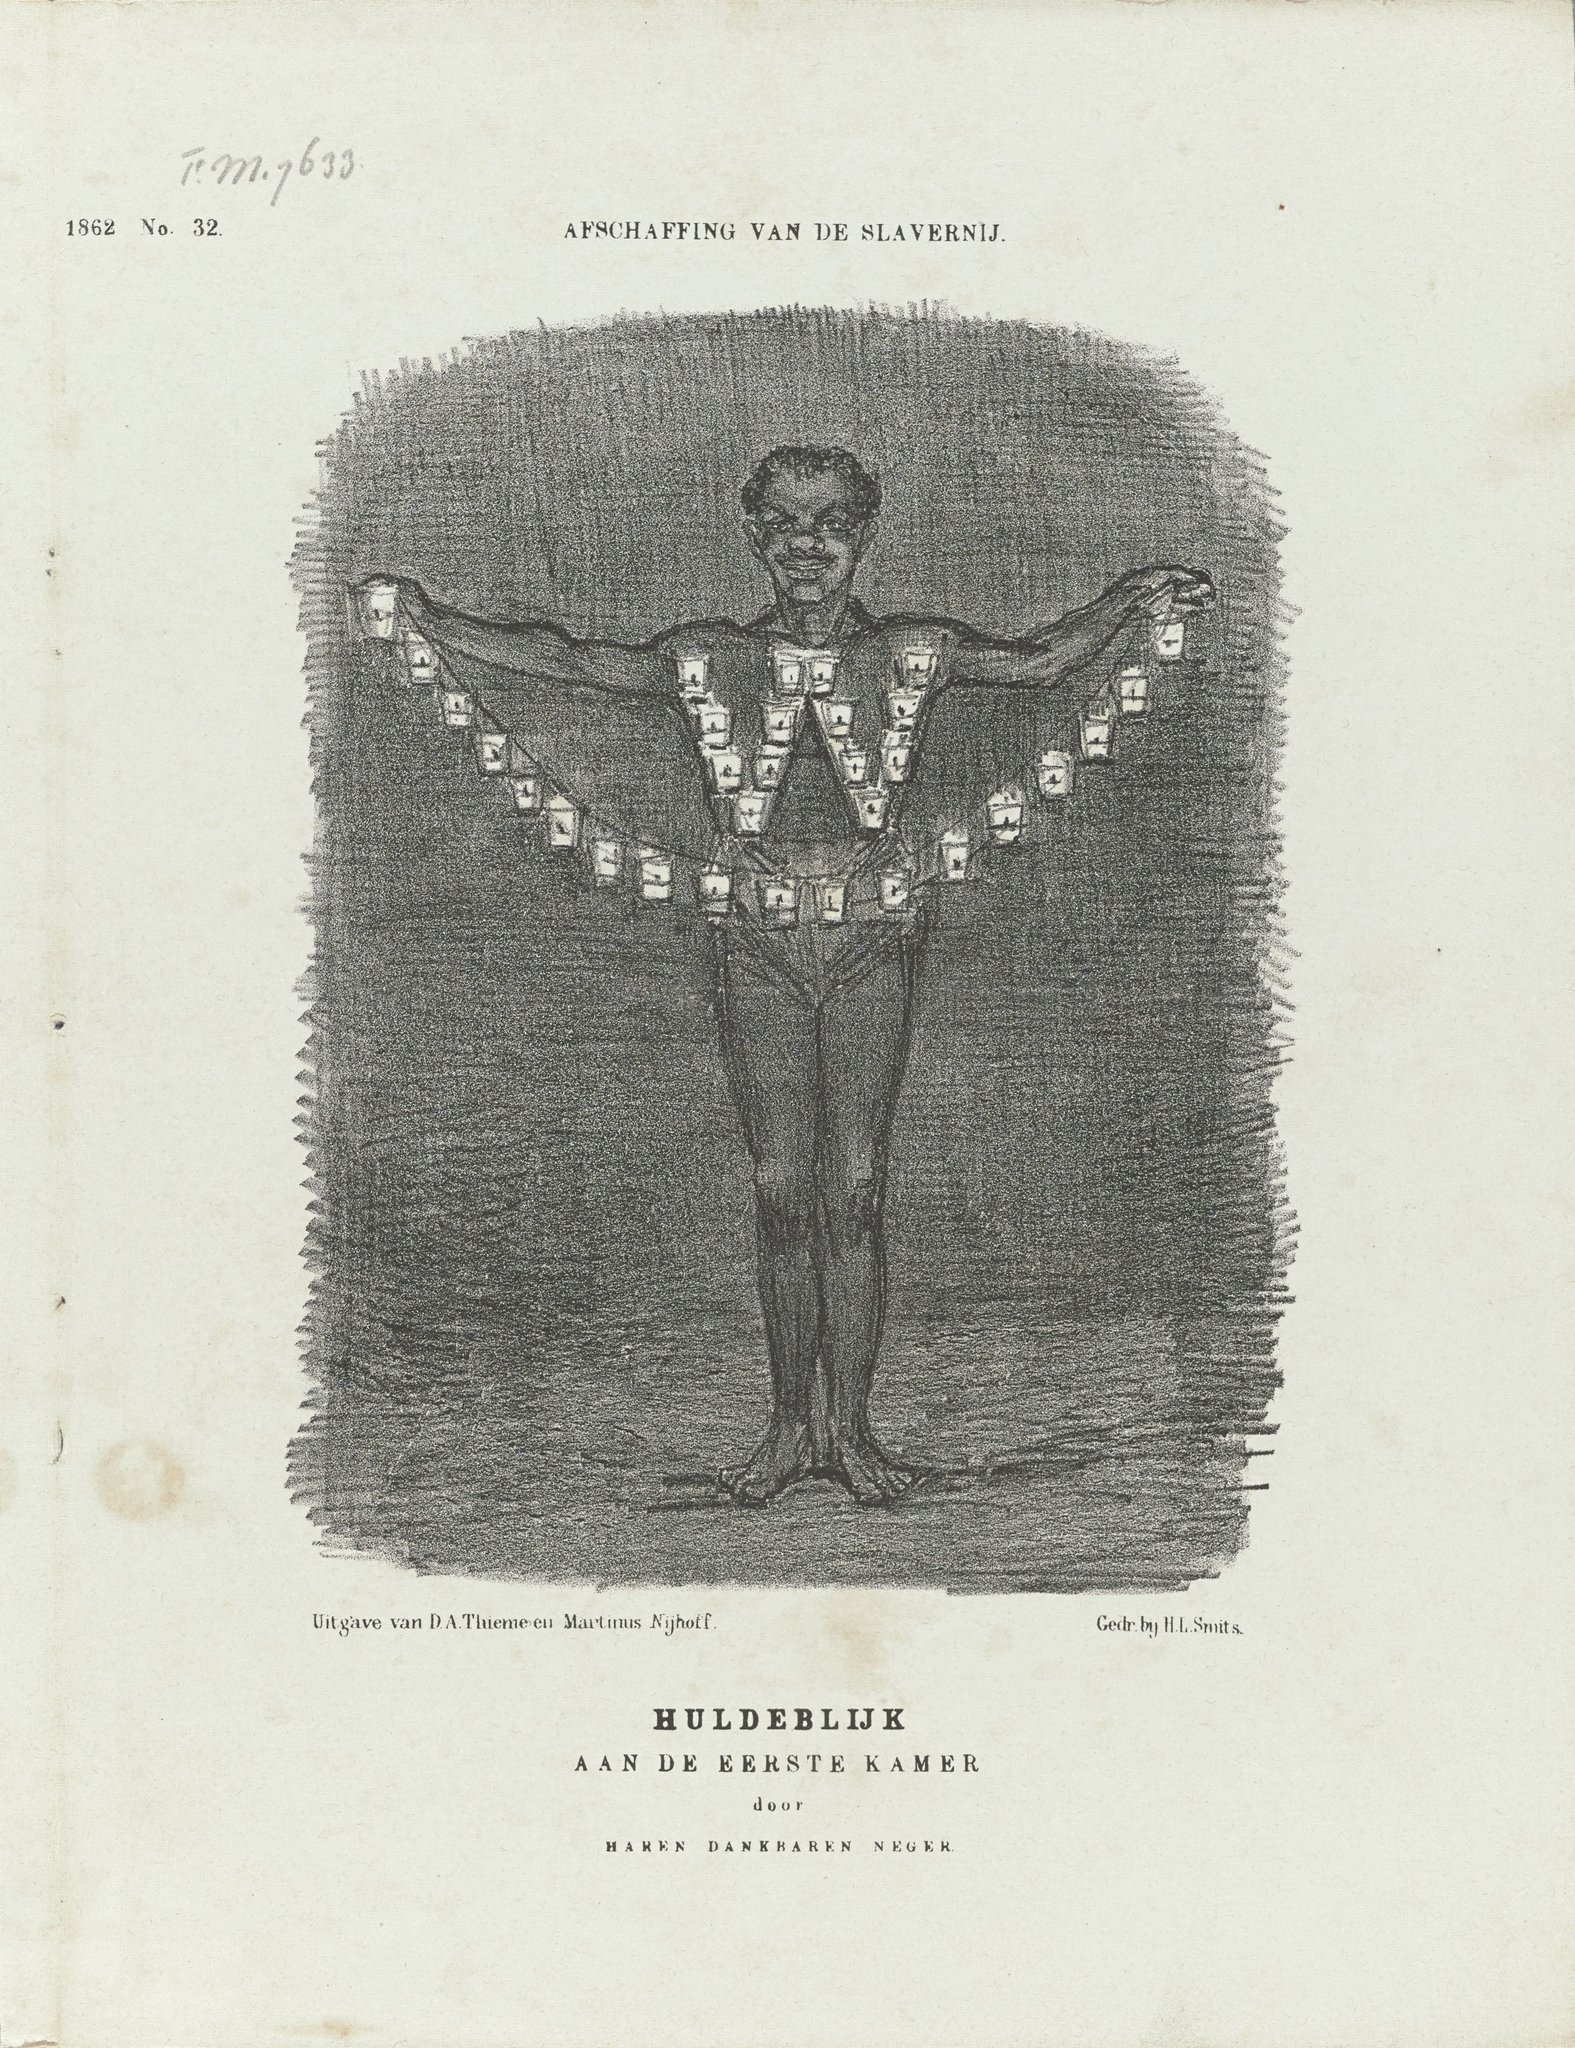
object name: cartoon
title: Afschaffing van de slavernij / Huldeblijk aan de Eerste Kamer door haren dankbaren neger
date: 1862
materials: paper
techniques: lithograph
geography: netherlands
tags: brussels, willem iii (koning der nederlanden), abolition of slavery, fighting slavery, suriname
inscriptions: collector's mark: Lugt 2228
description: Spotprent naar aanleiding van de afschaffing van de slavernij. Een tot slaaf gemaakte man van Afrikaanse oorsprong met een slinger van lichtjes en de letter W in lichtjes op zijn borst. De wet om de slavernij in Suriname en de Nederlandse Antillen op te heffen werd in 1862 aangenomen. Plaat verschenen bij het weekblad De Nederlandsche Spectator, nr. 32, 9 augustus 1862.